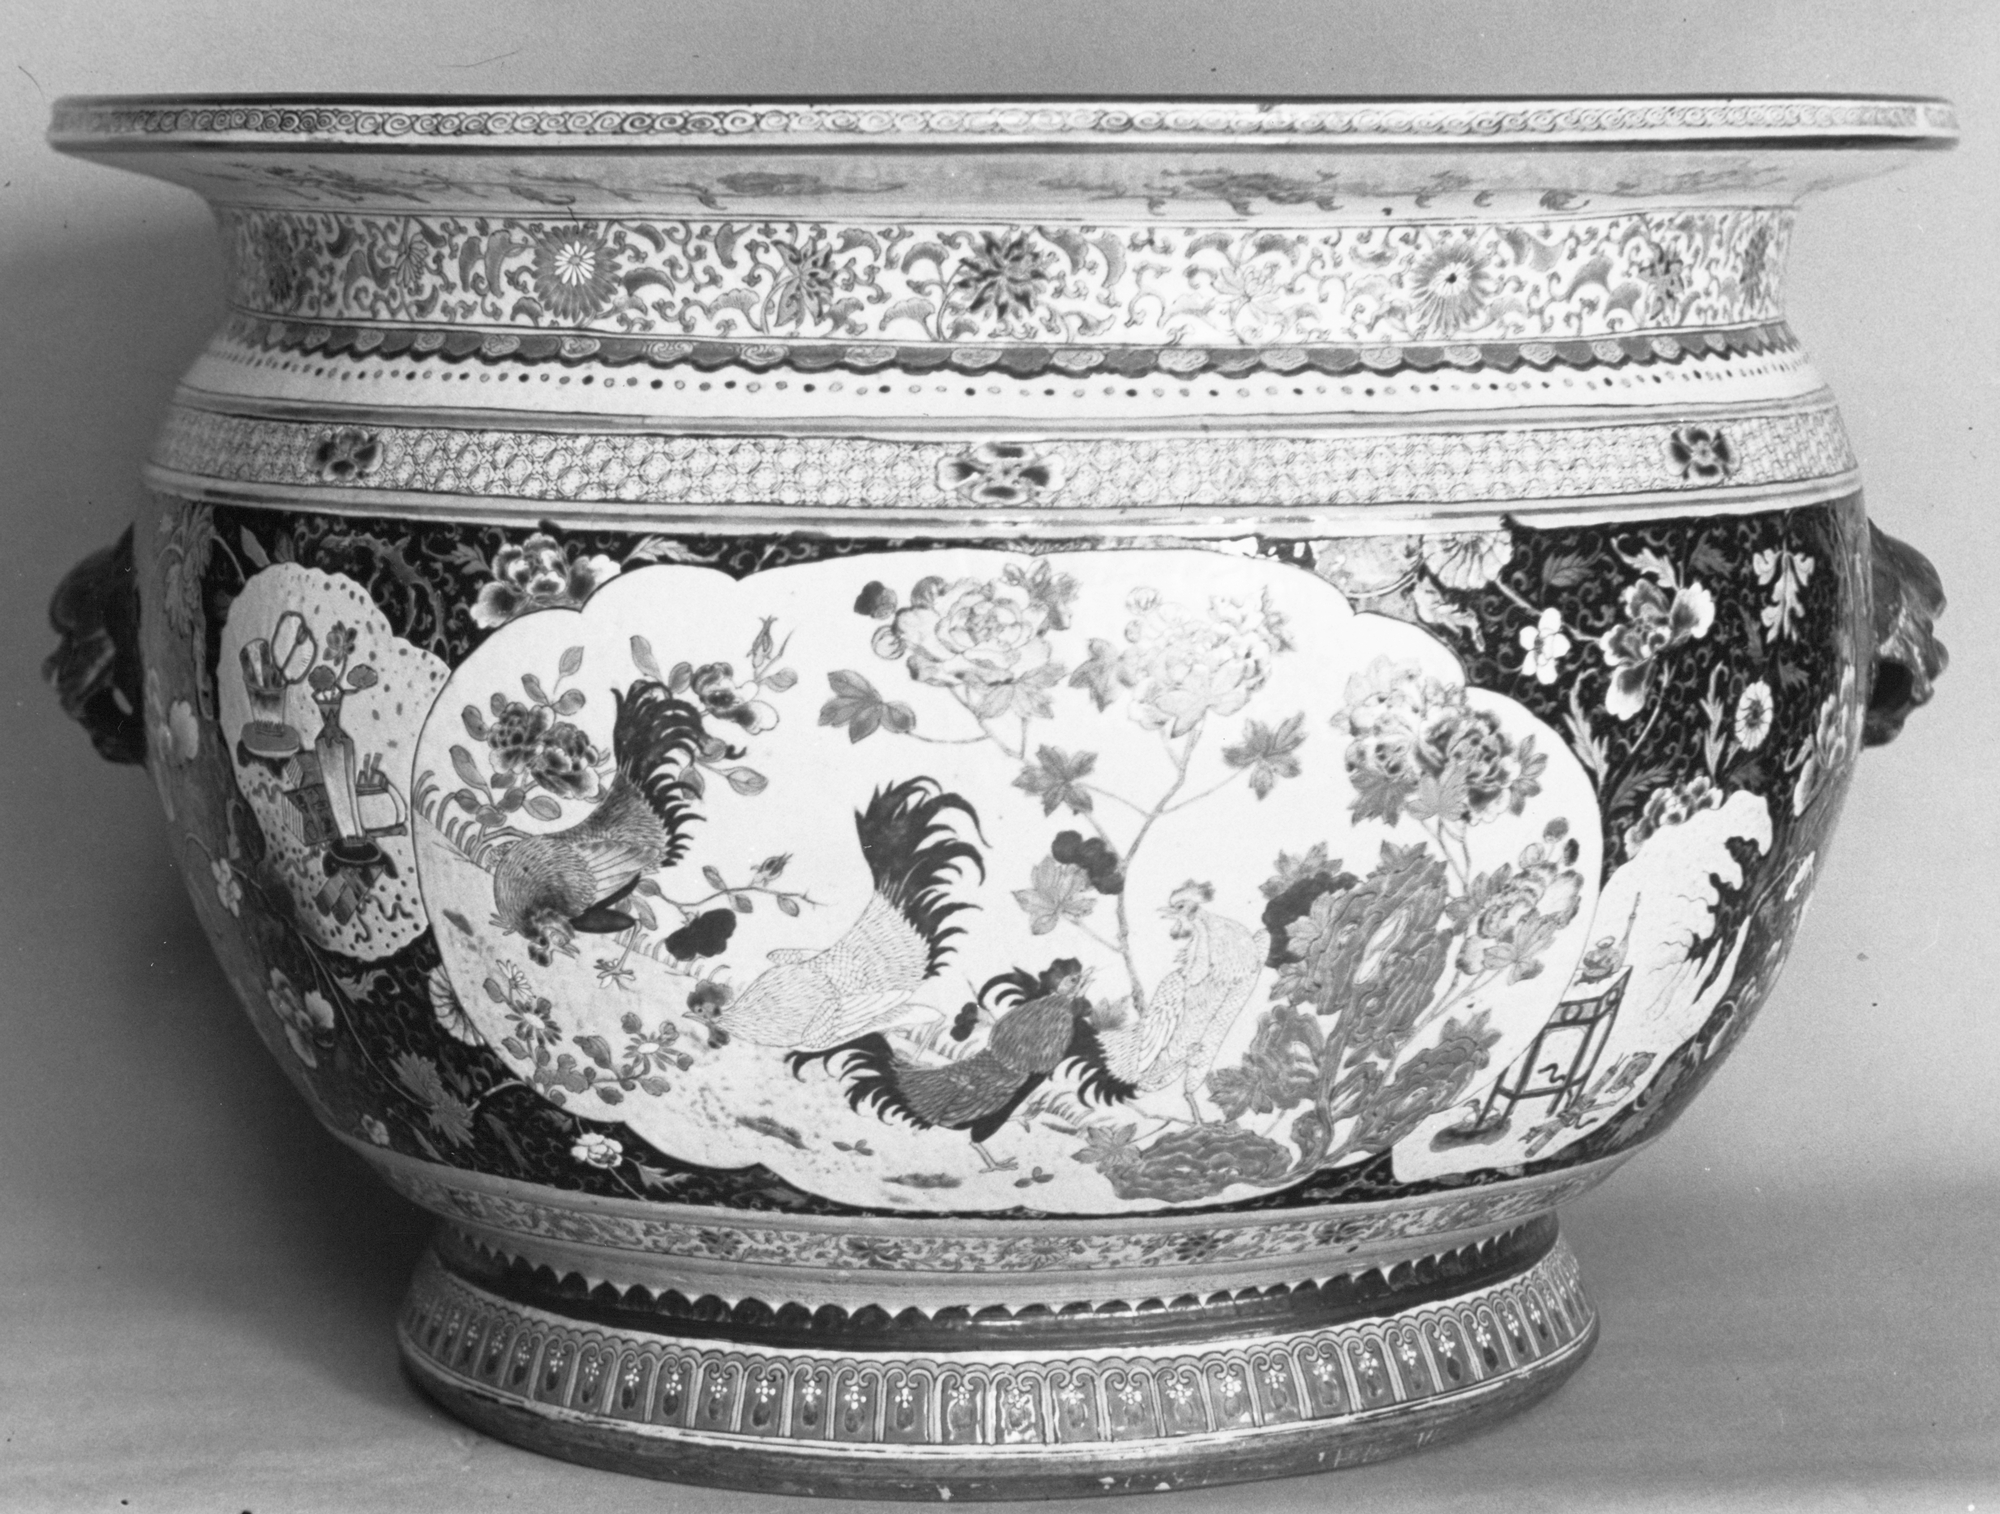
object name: basin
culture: chinese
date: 1736-1795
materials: enamel, porcelain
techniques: overglaze, painting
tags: roosters